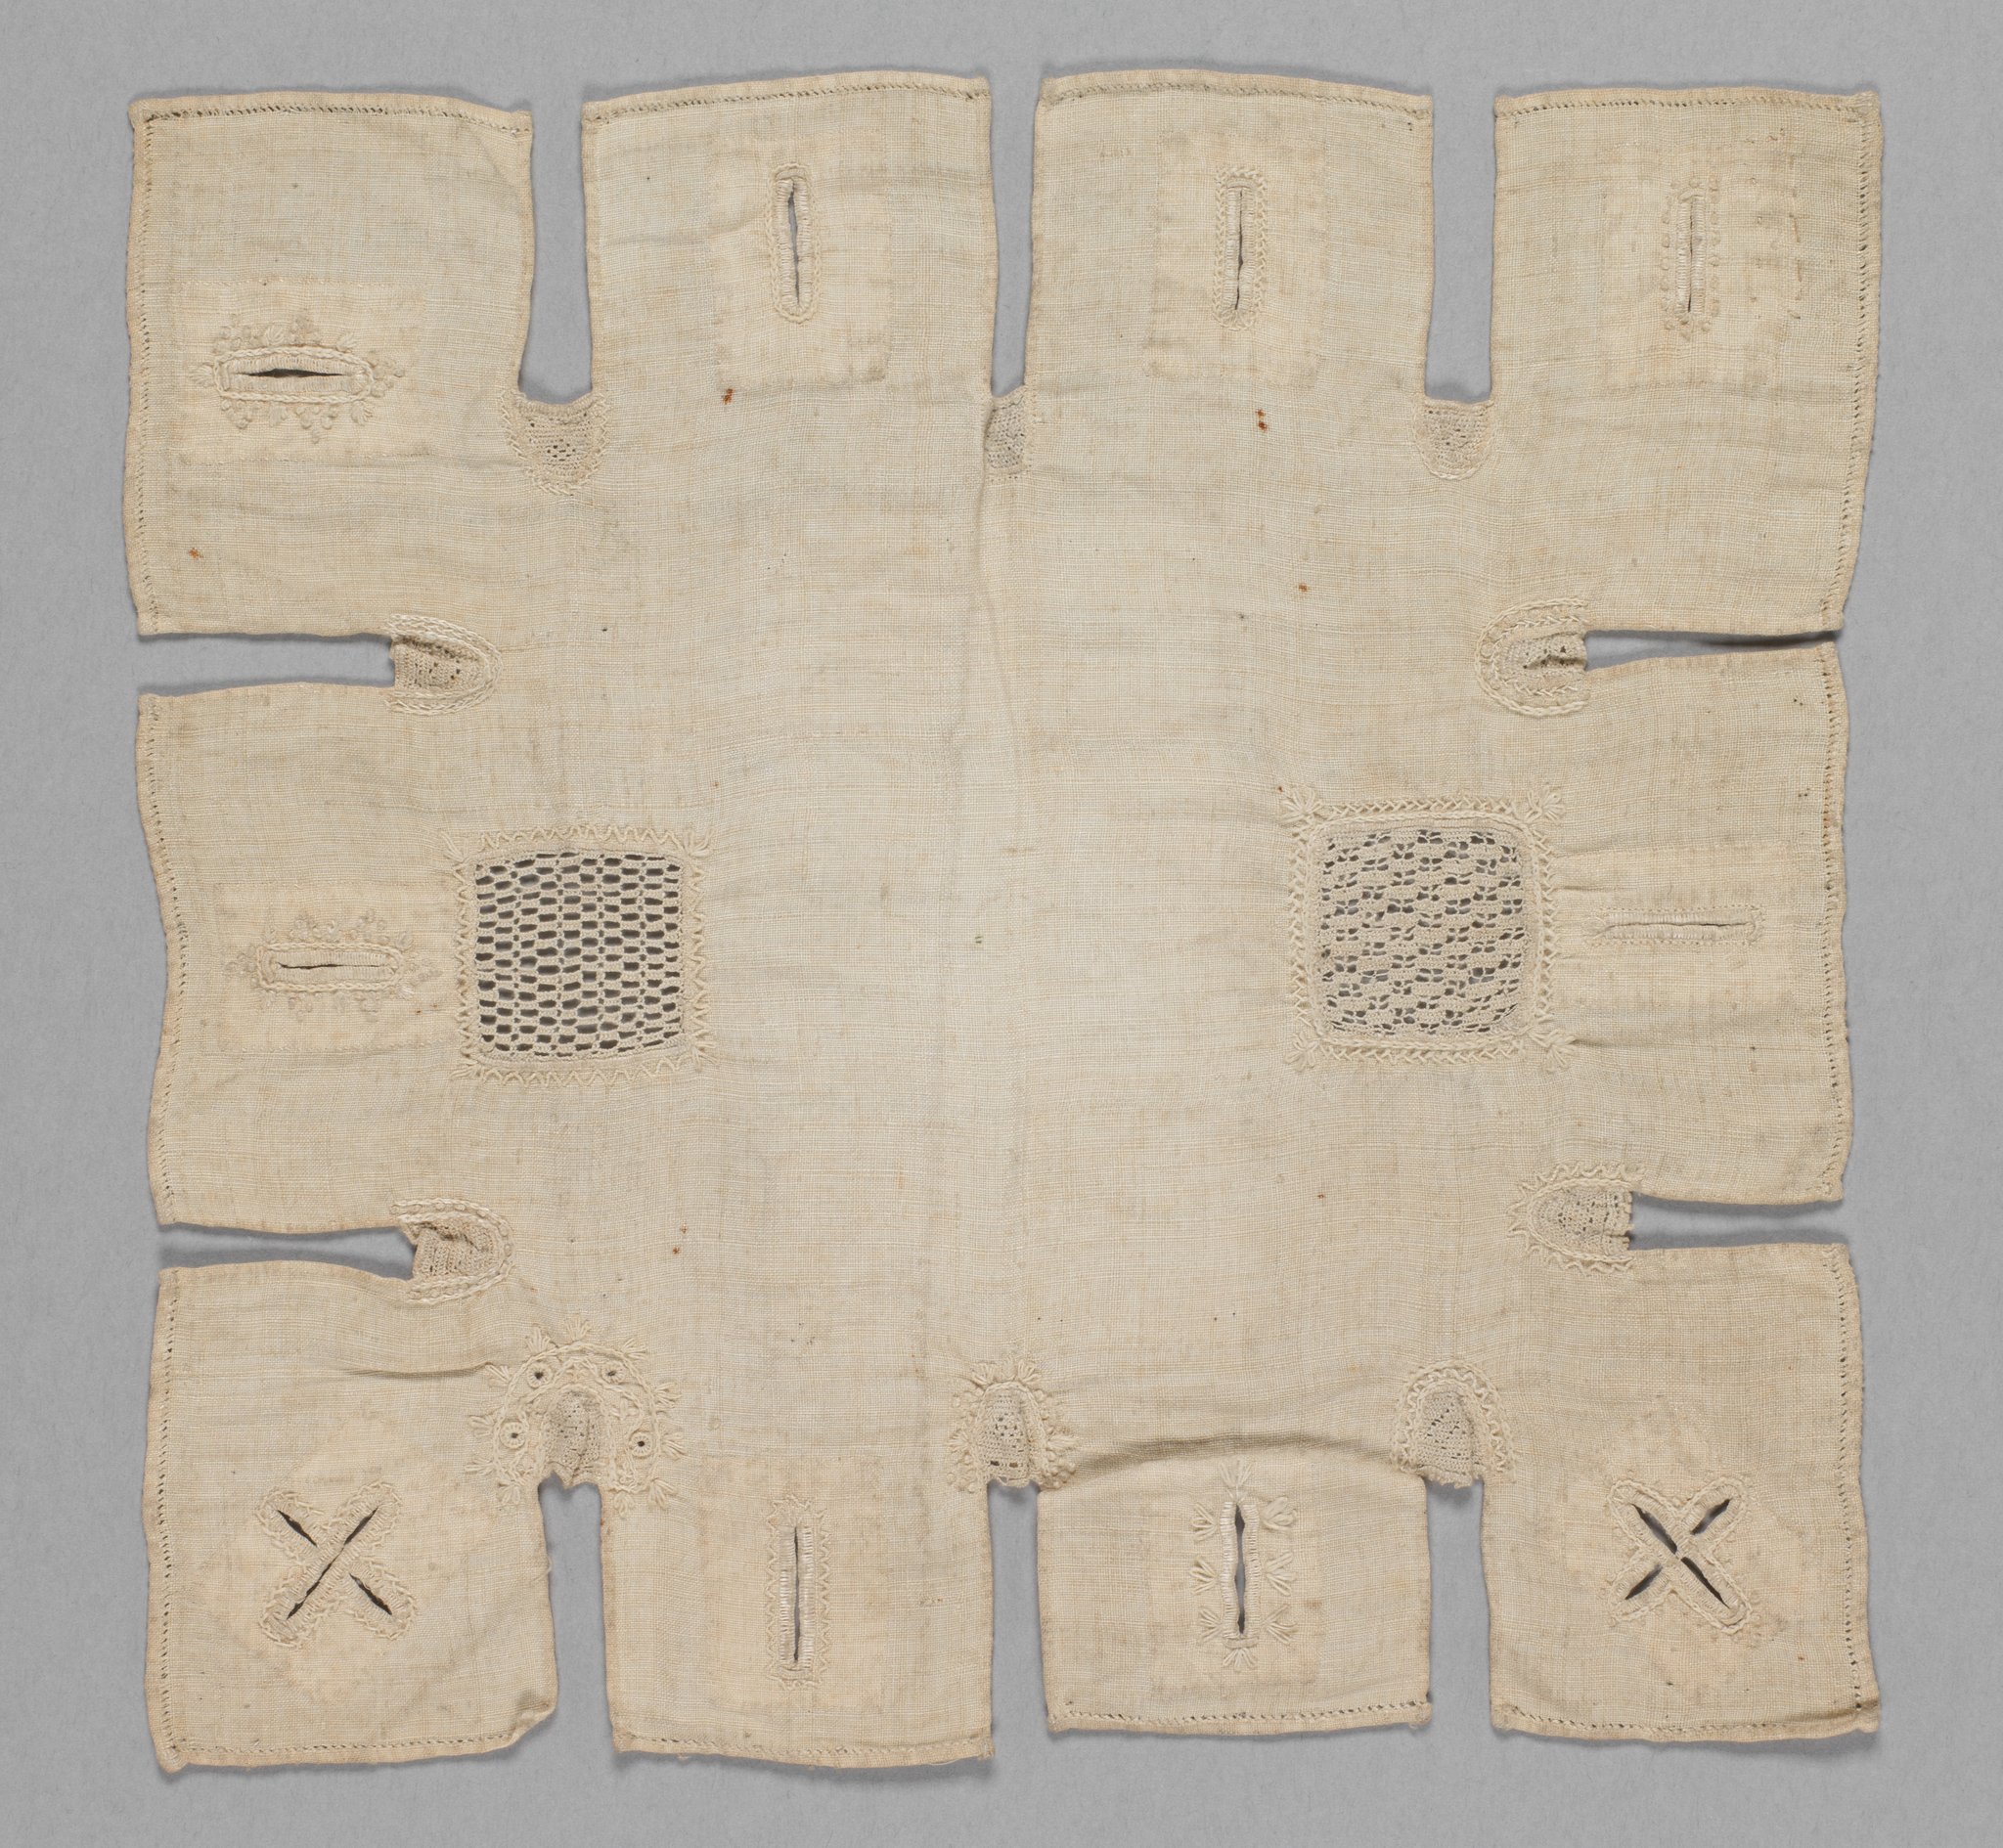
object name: sampler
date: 1701-1800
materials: cotton, linen